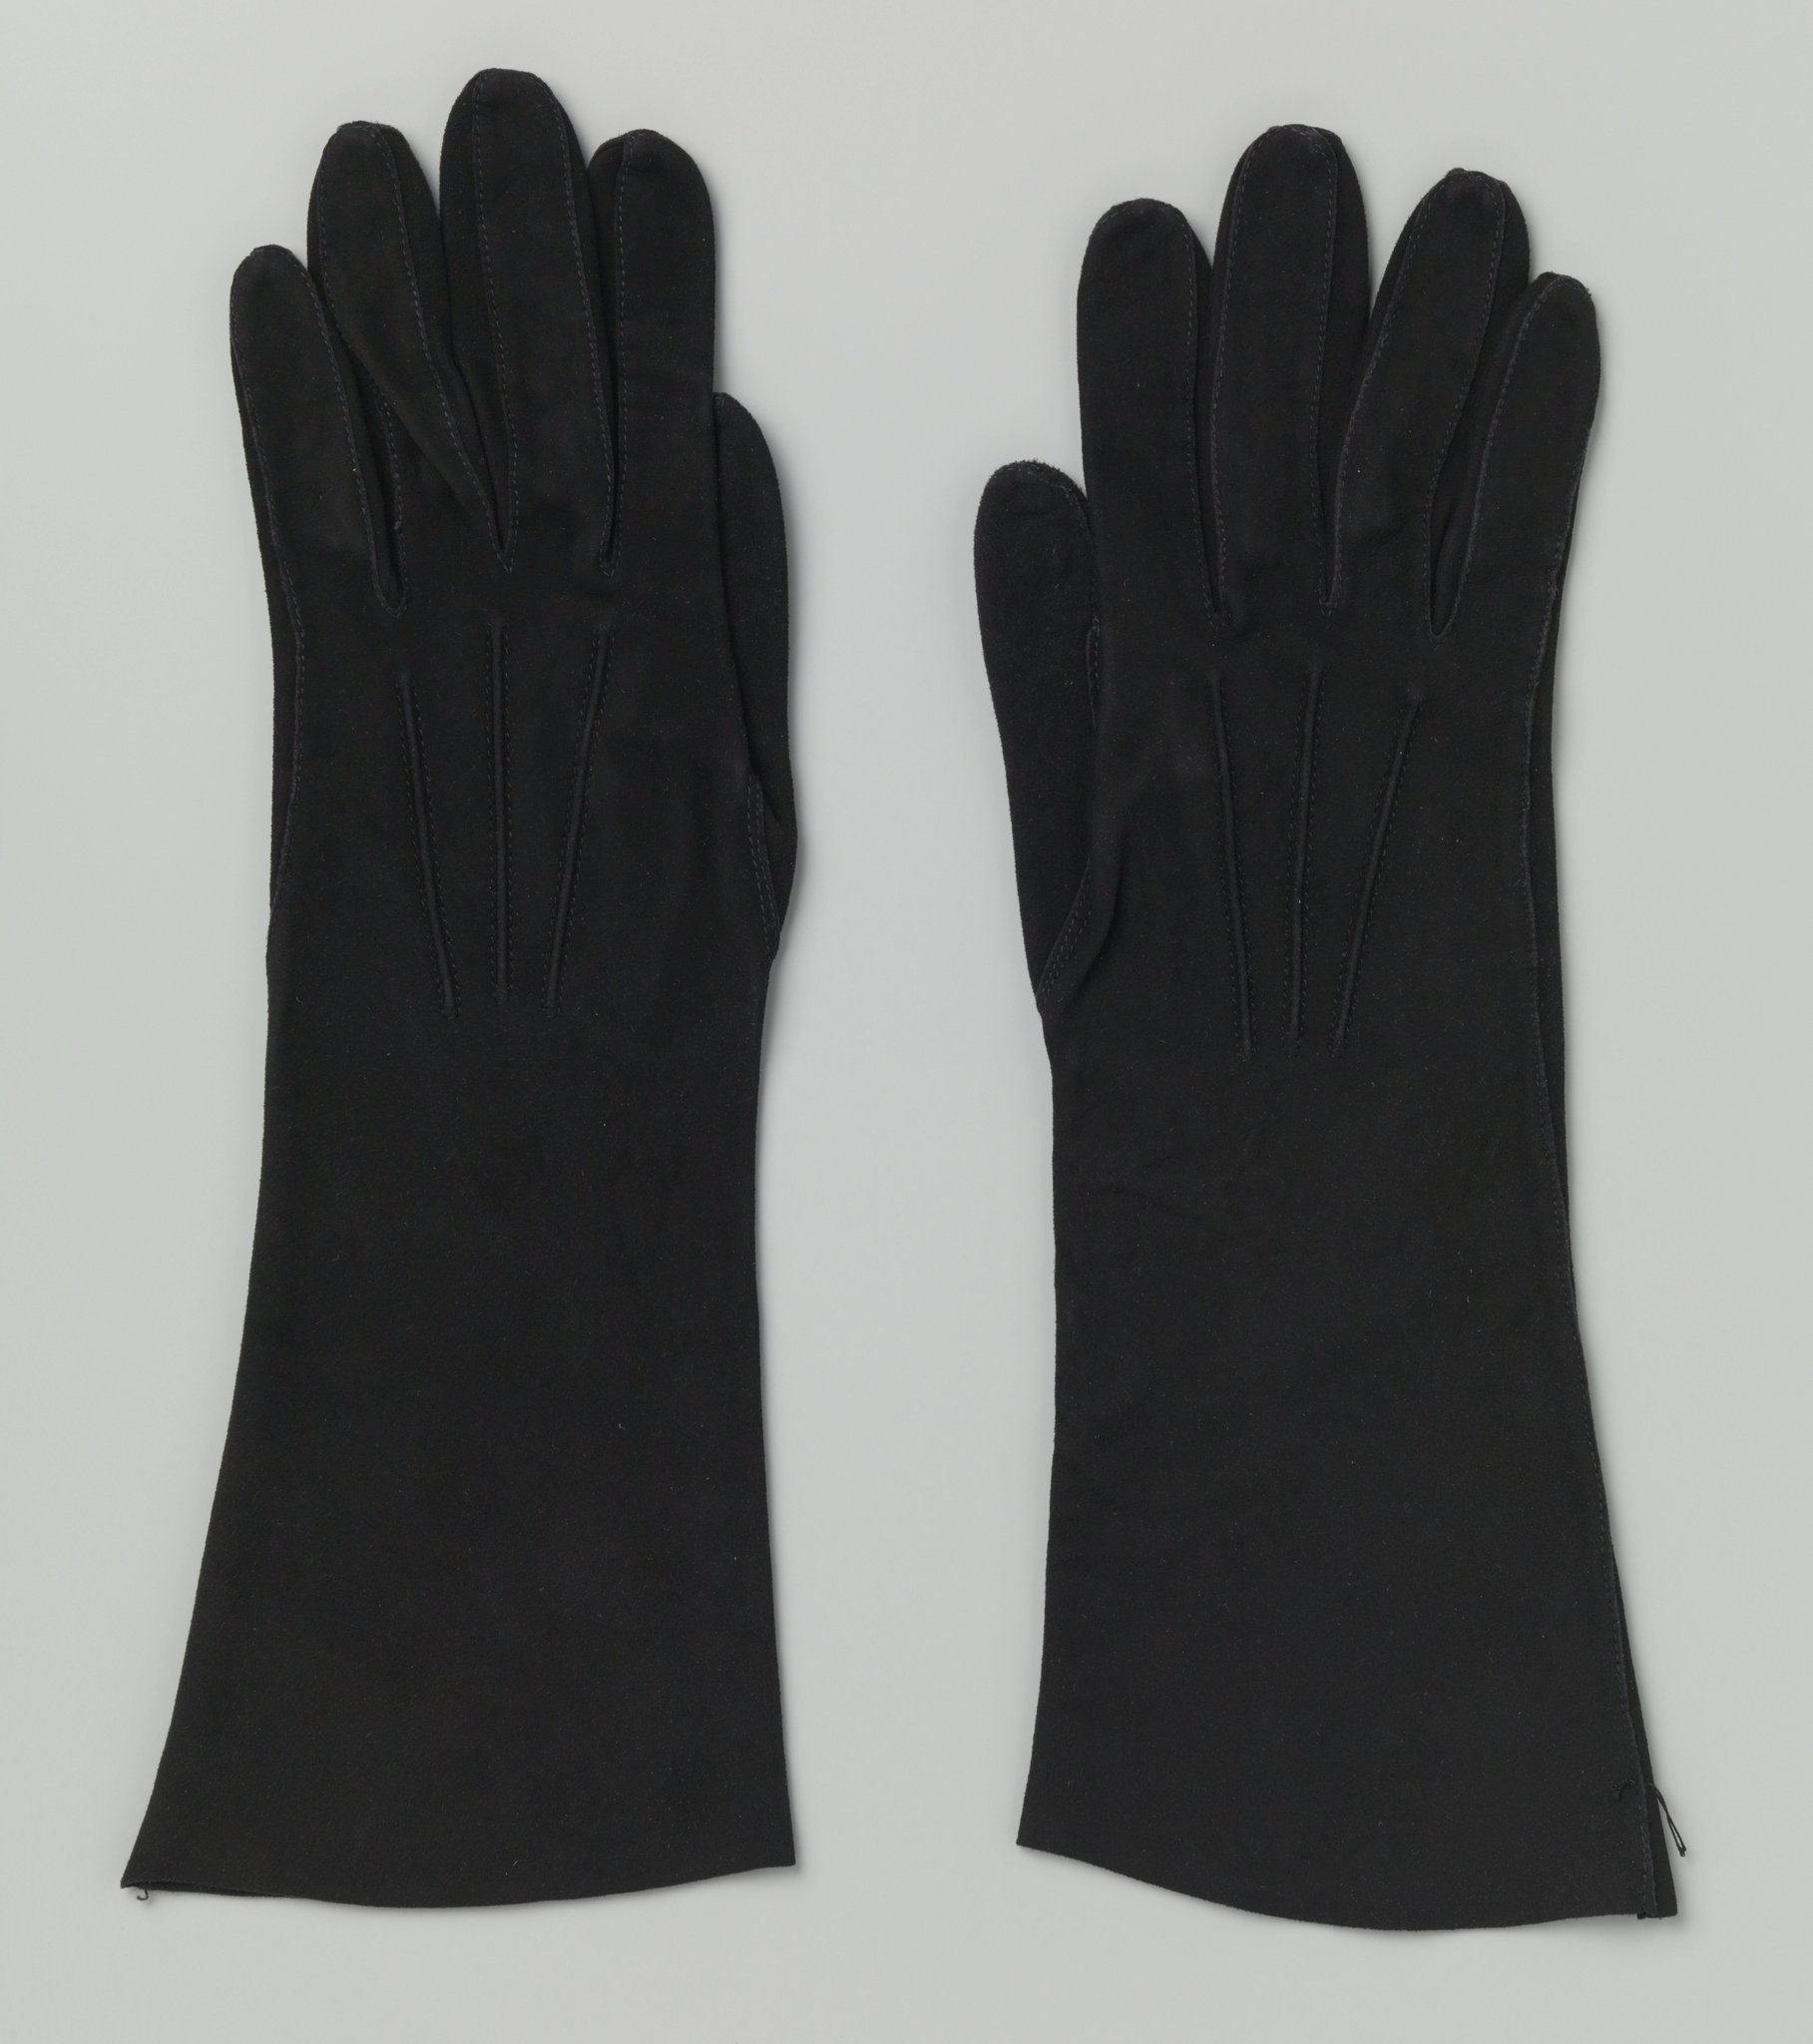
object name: glove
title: Handschoen van zwart zeemleer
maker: Anonymous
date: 1950-1960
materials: leather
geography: france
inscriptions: stamp: ‘afbeelding; tekst’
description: Linker handschoen van zwart zeemleer. Op de hand drie uitstralende koorden.